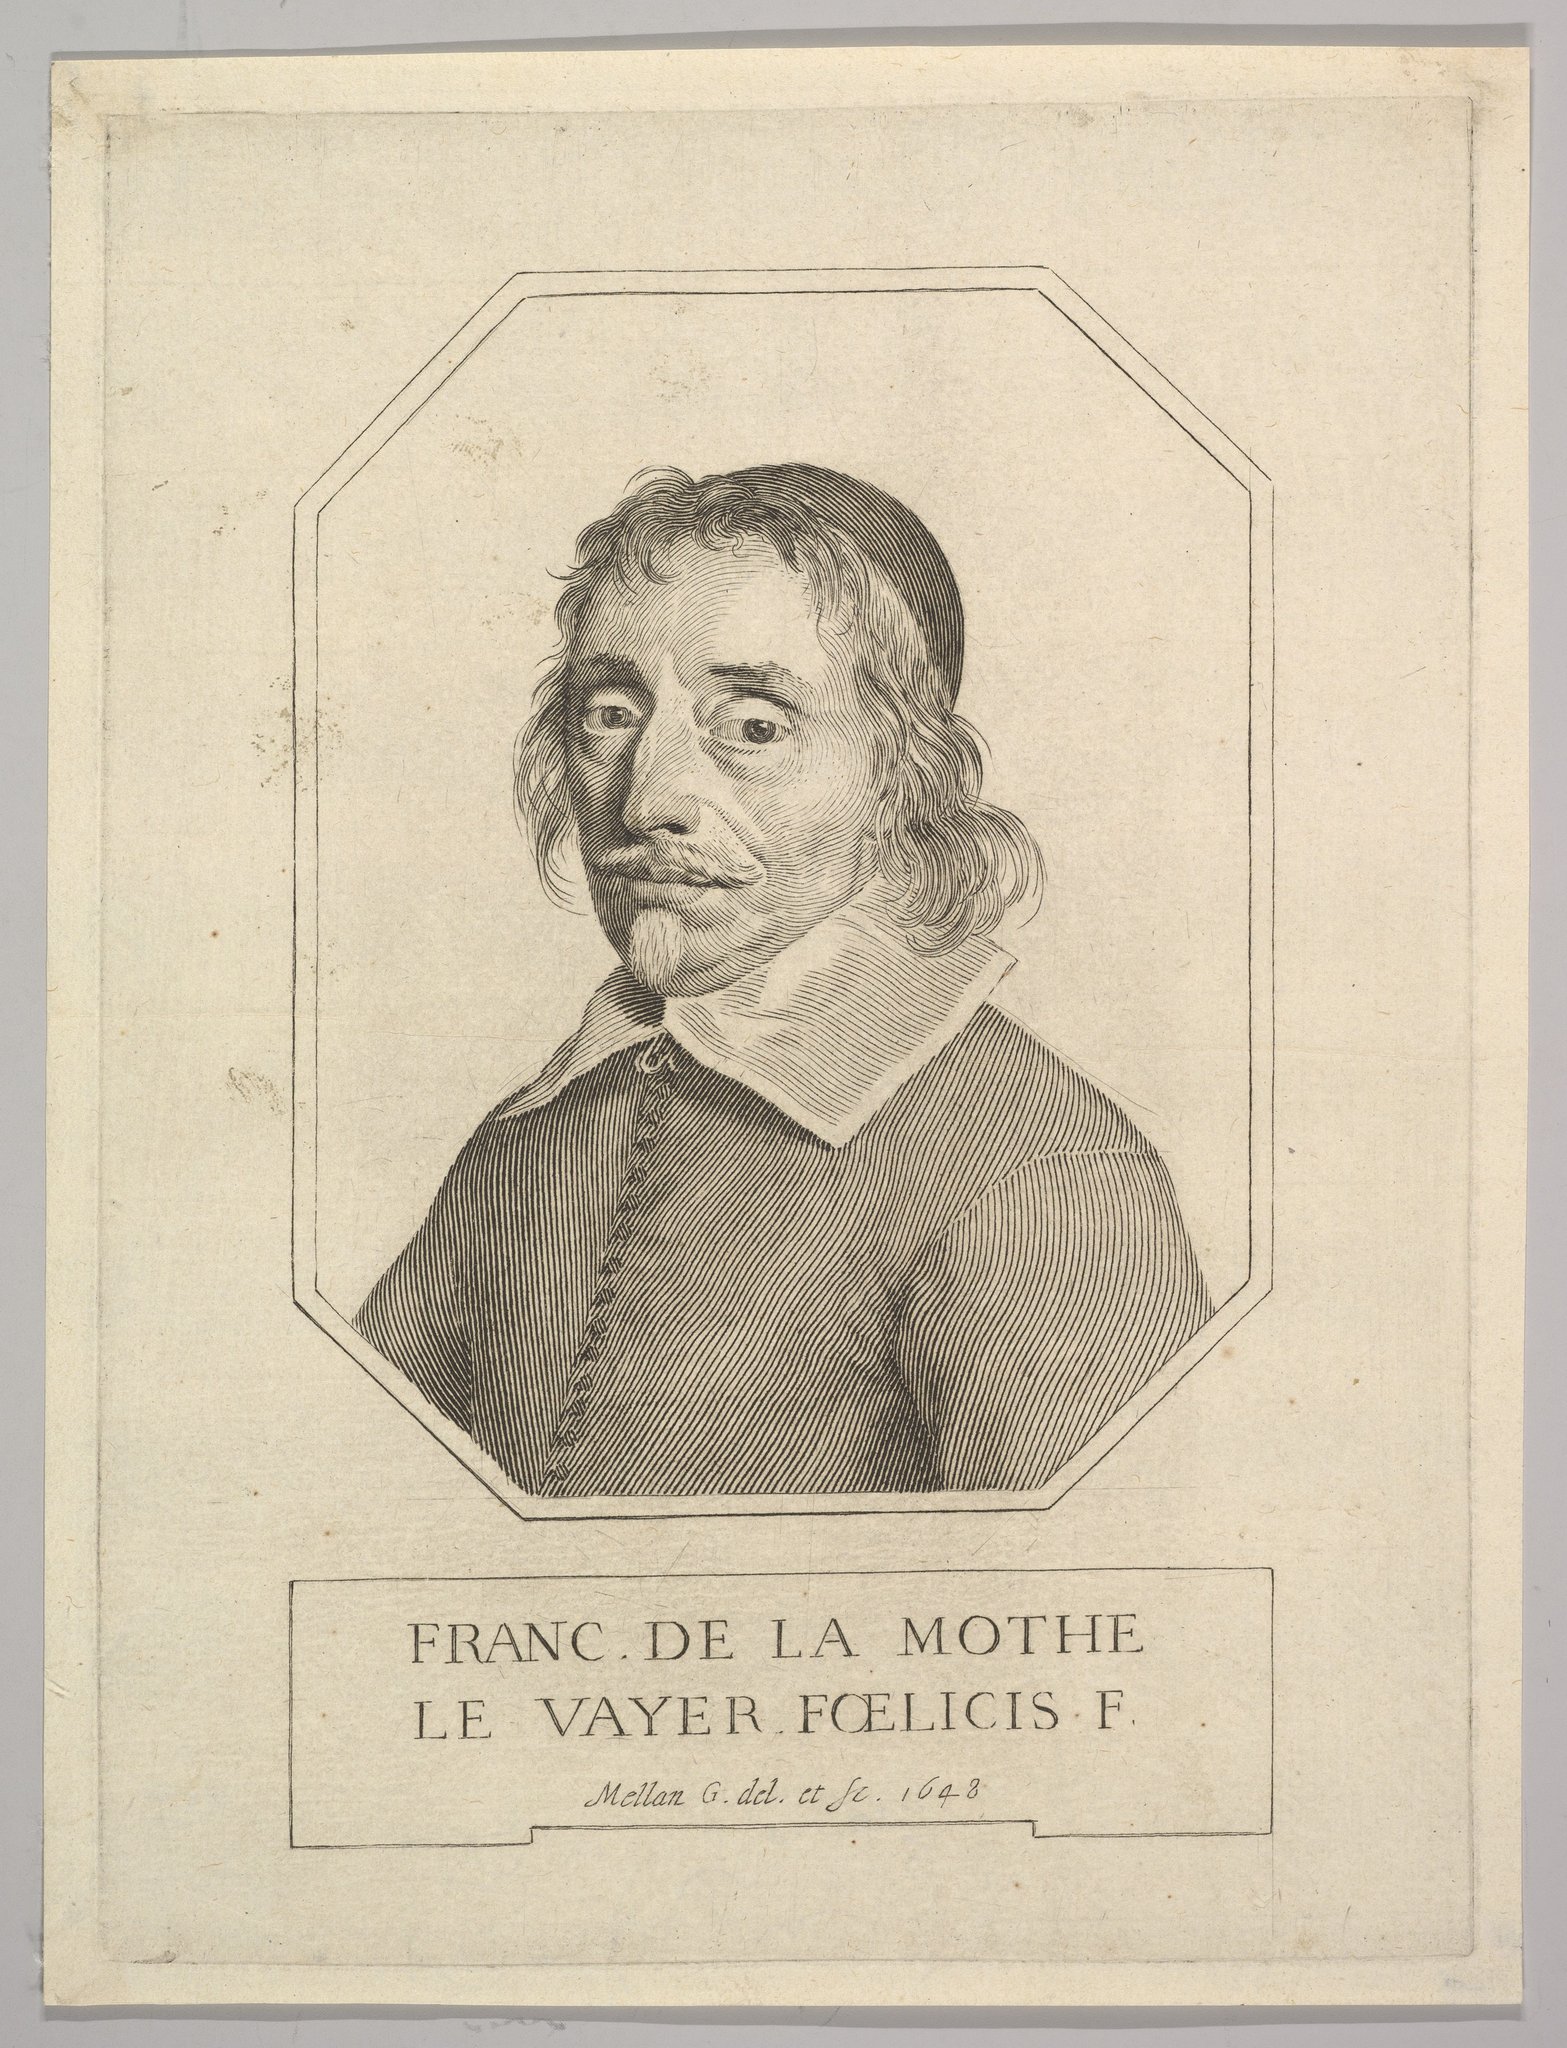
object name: print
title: François de La Mothe Le Vayer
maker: claude mellan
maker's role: artist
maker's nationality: french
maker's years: 1598-1688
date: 1648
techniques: engraving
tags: men,portraits